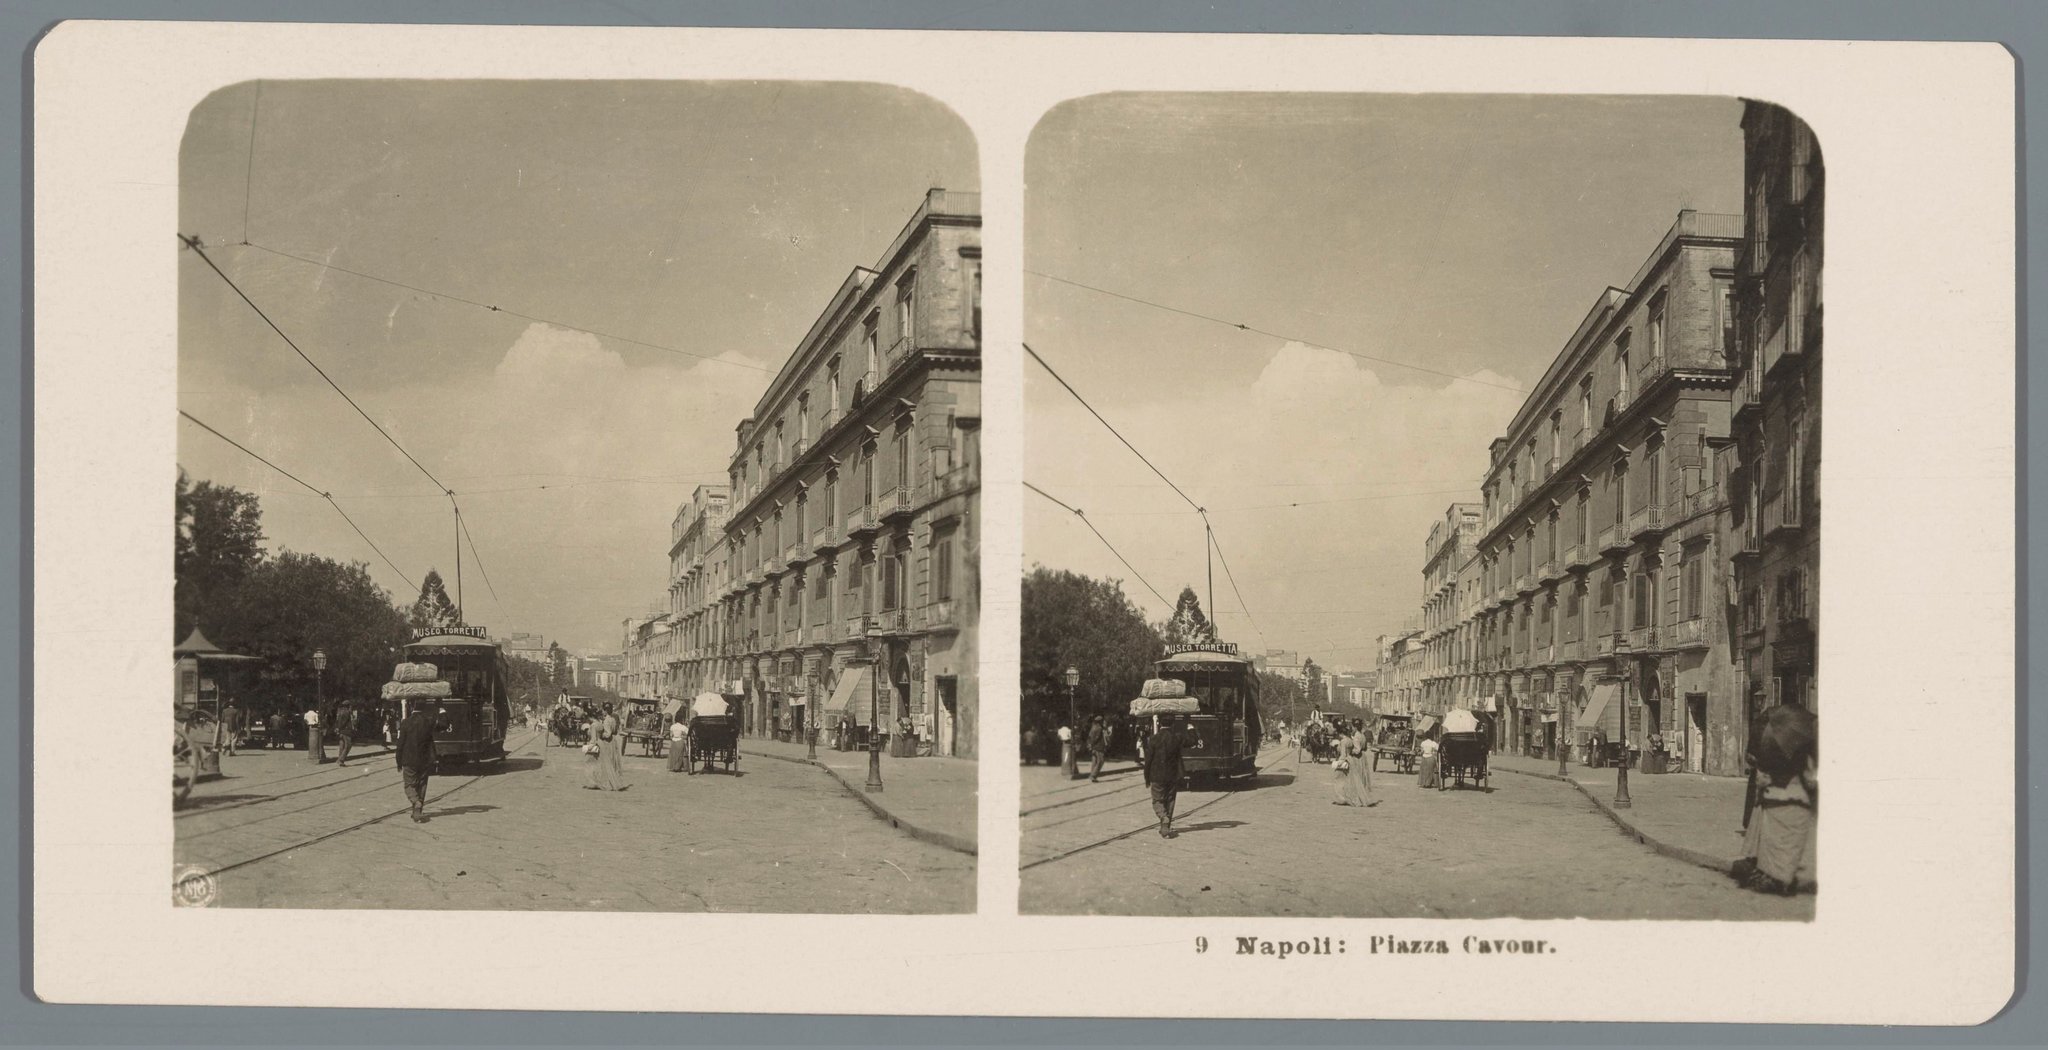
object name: stereograph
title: Gezicht op het Piazza Cavour te Napels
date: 1900-1910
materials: cardboard, photographic support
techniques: gelatin silver print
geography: piazza cavour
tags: tram, façade (of house or building), village square, place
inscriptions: number: ‘9’, inscription: ‘NPG’